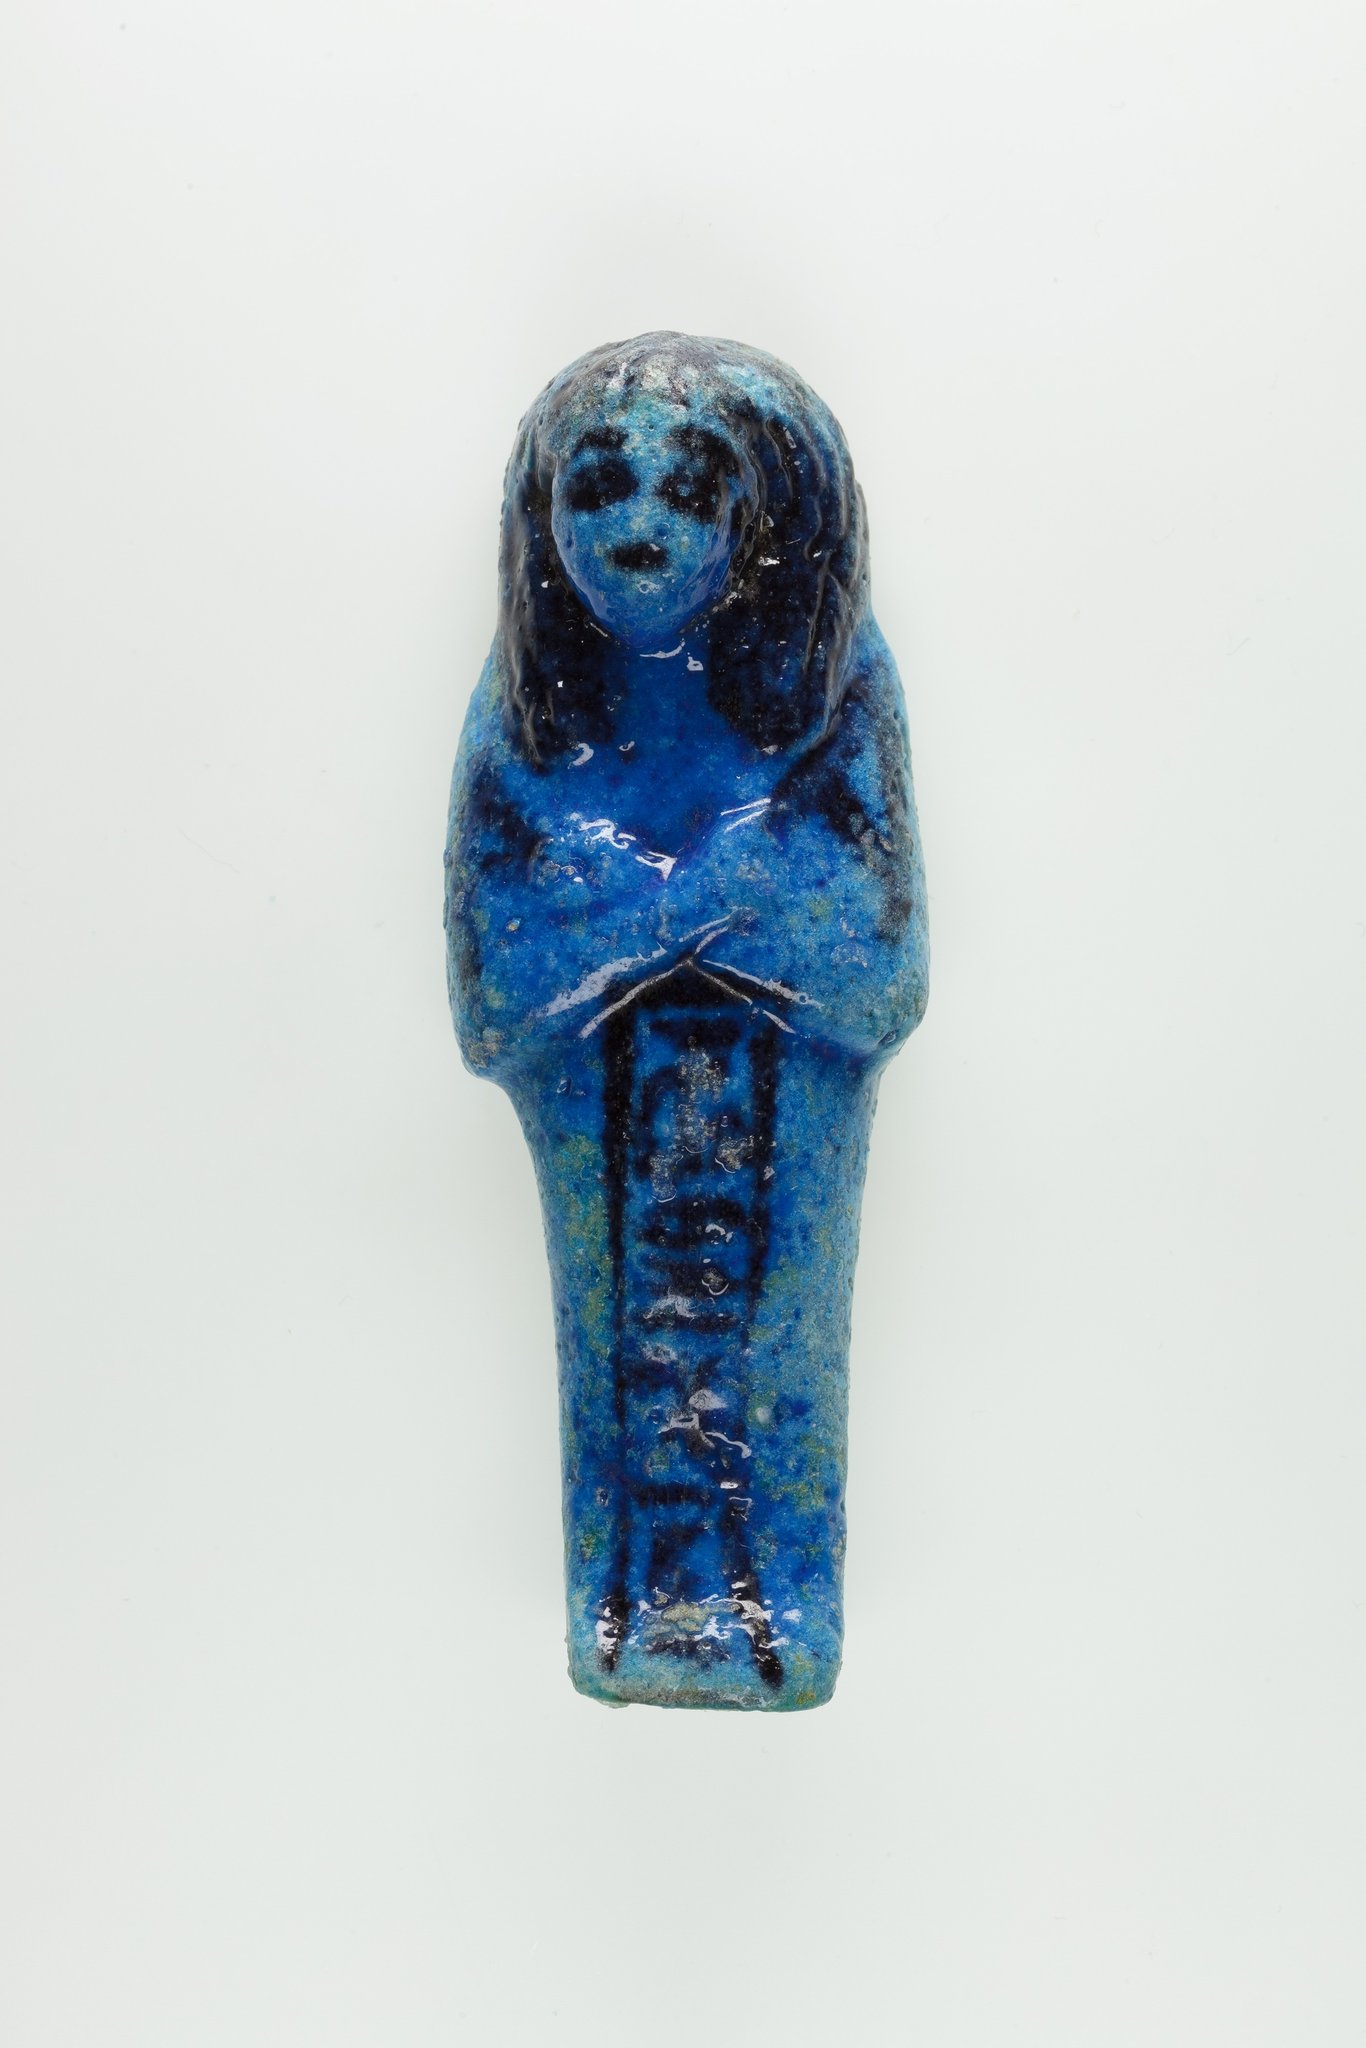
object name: shabti, worker, nauny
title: Worker Shabti of Nauny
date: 1050 BCE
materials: faience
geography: egypt